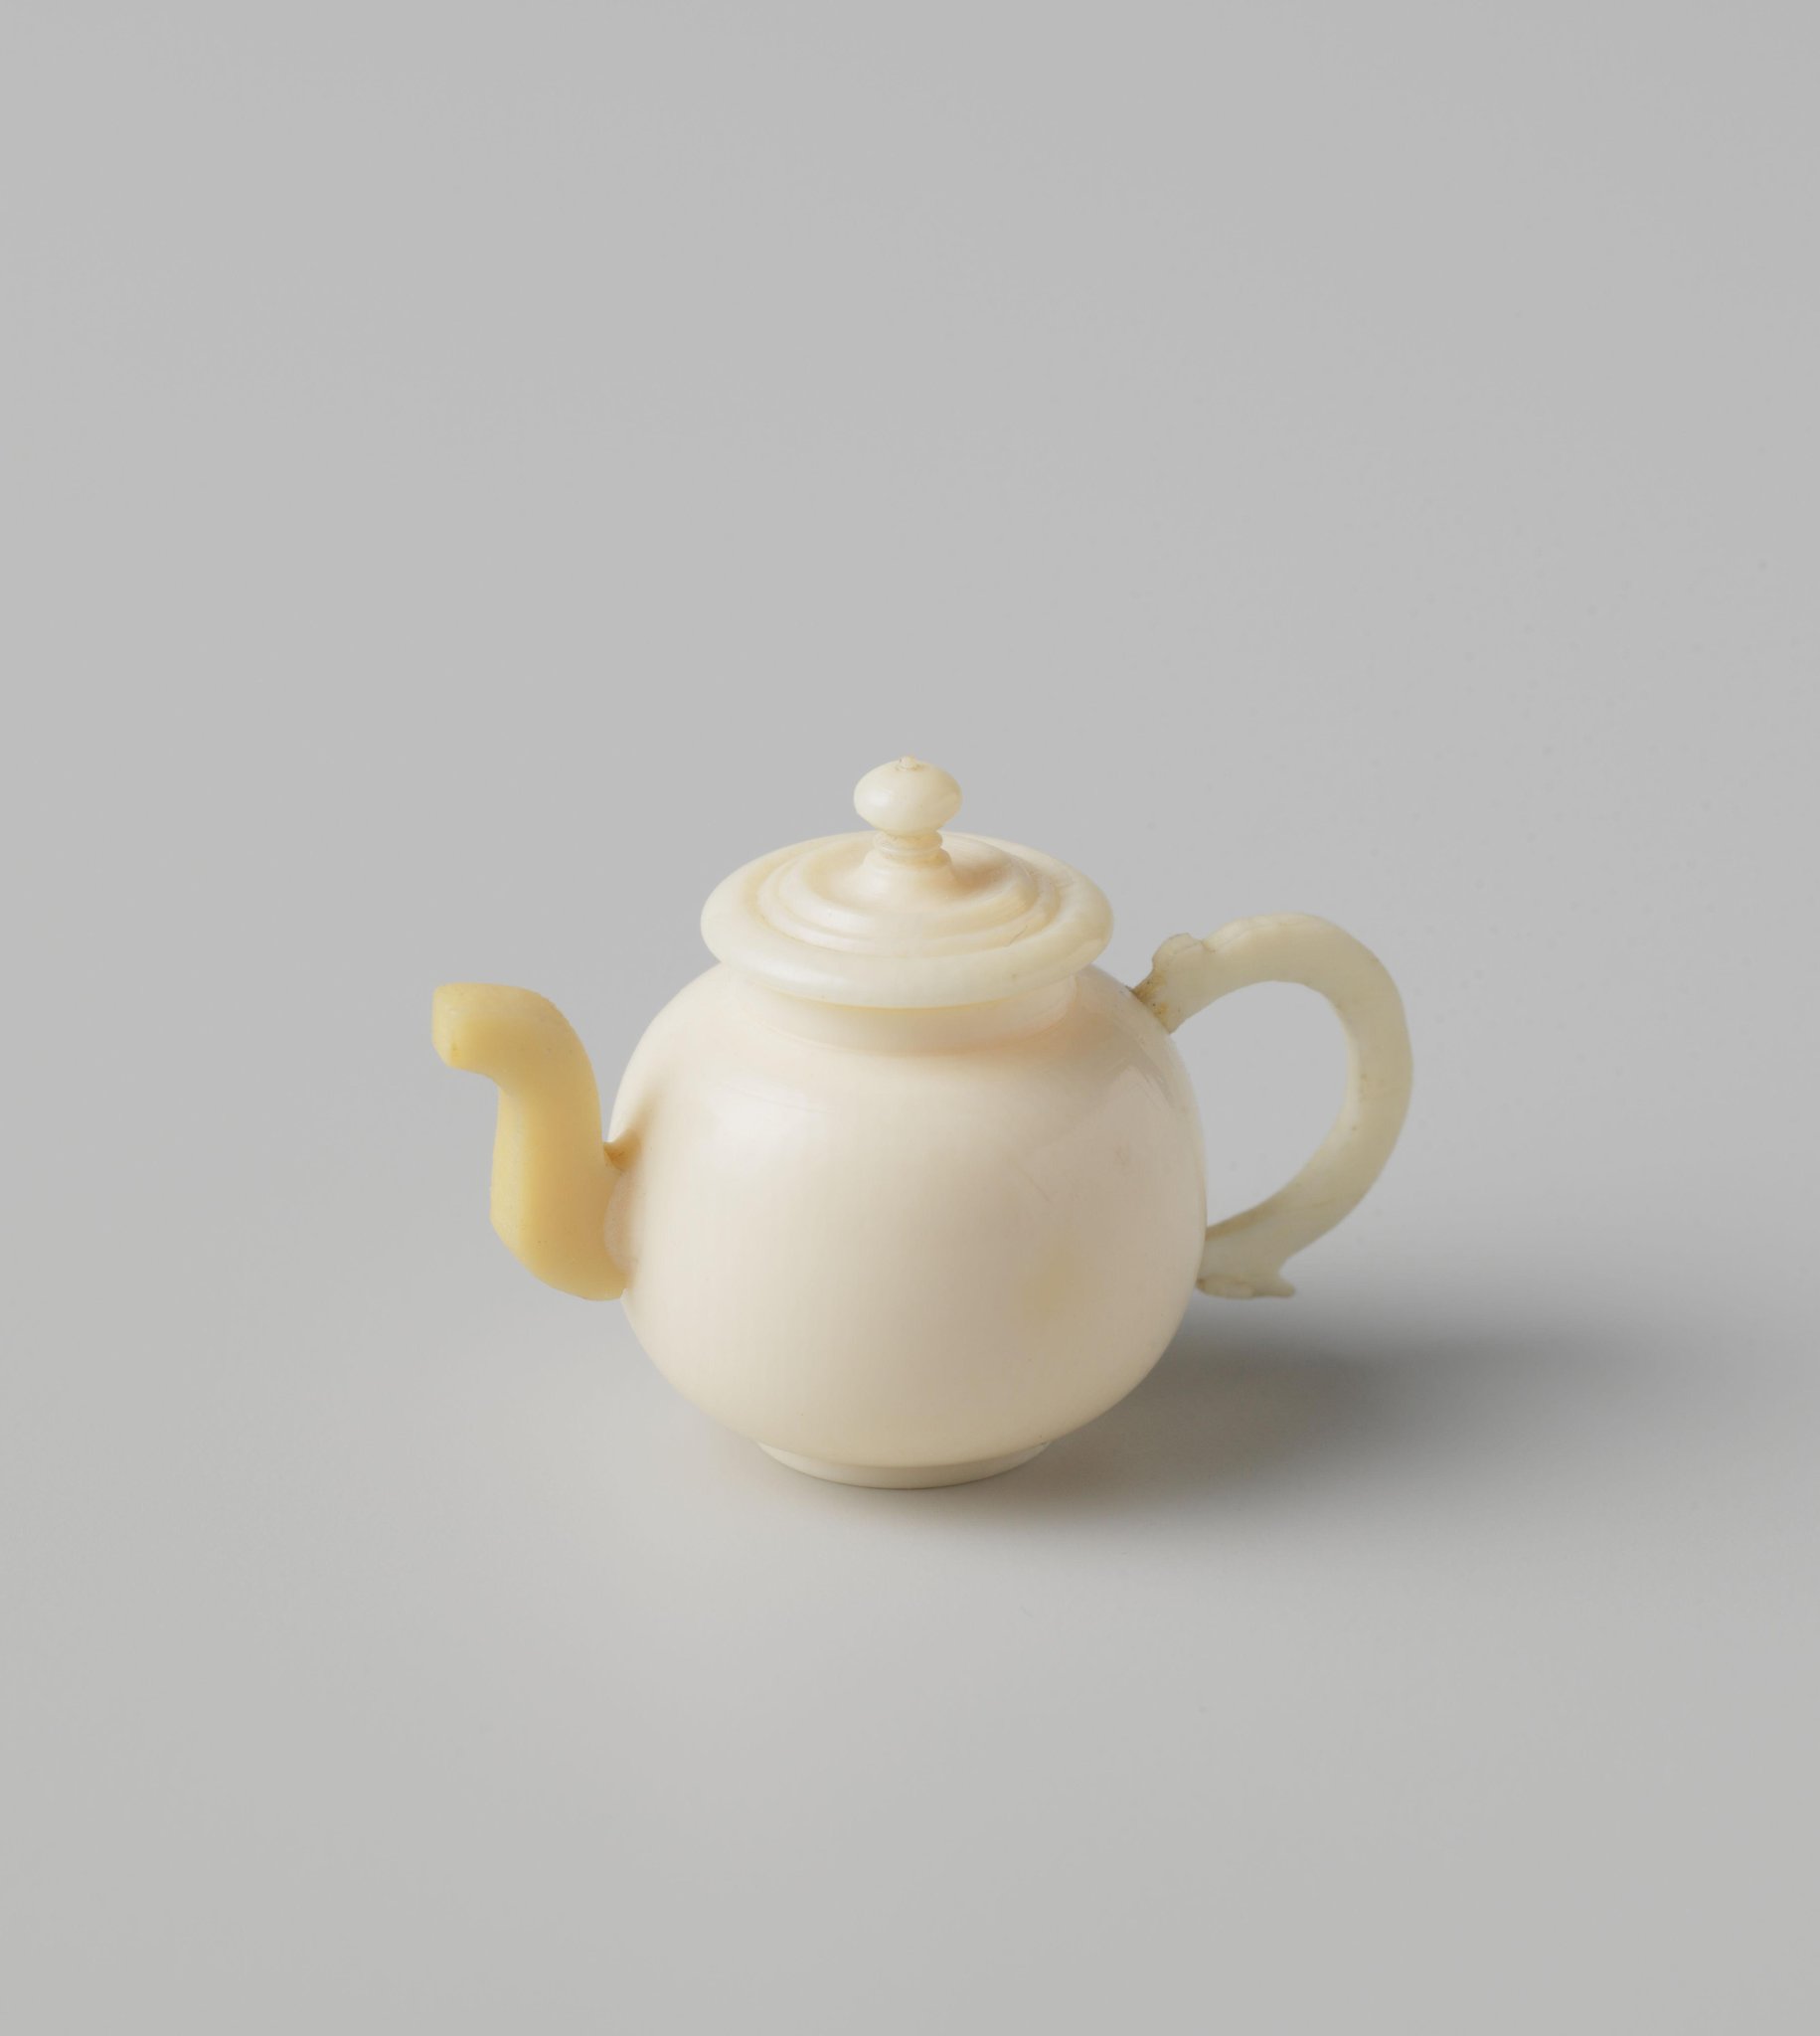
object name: teapot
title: Theepot met deksel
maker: Anonymous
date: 1700-1799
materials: ivory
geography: germany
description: Trekpot van ivoor, hol, met losse deksel met gedraaide profielranden en knop; massief uitgezaagde tuit en handvat.